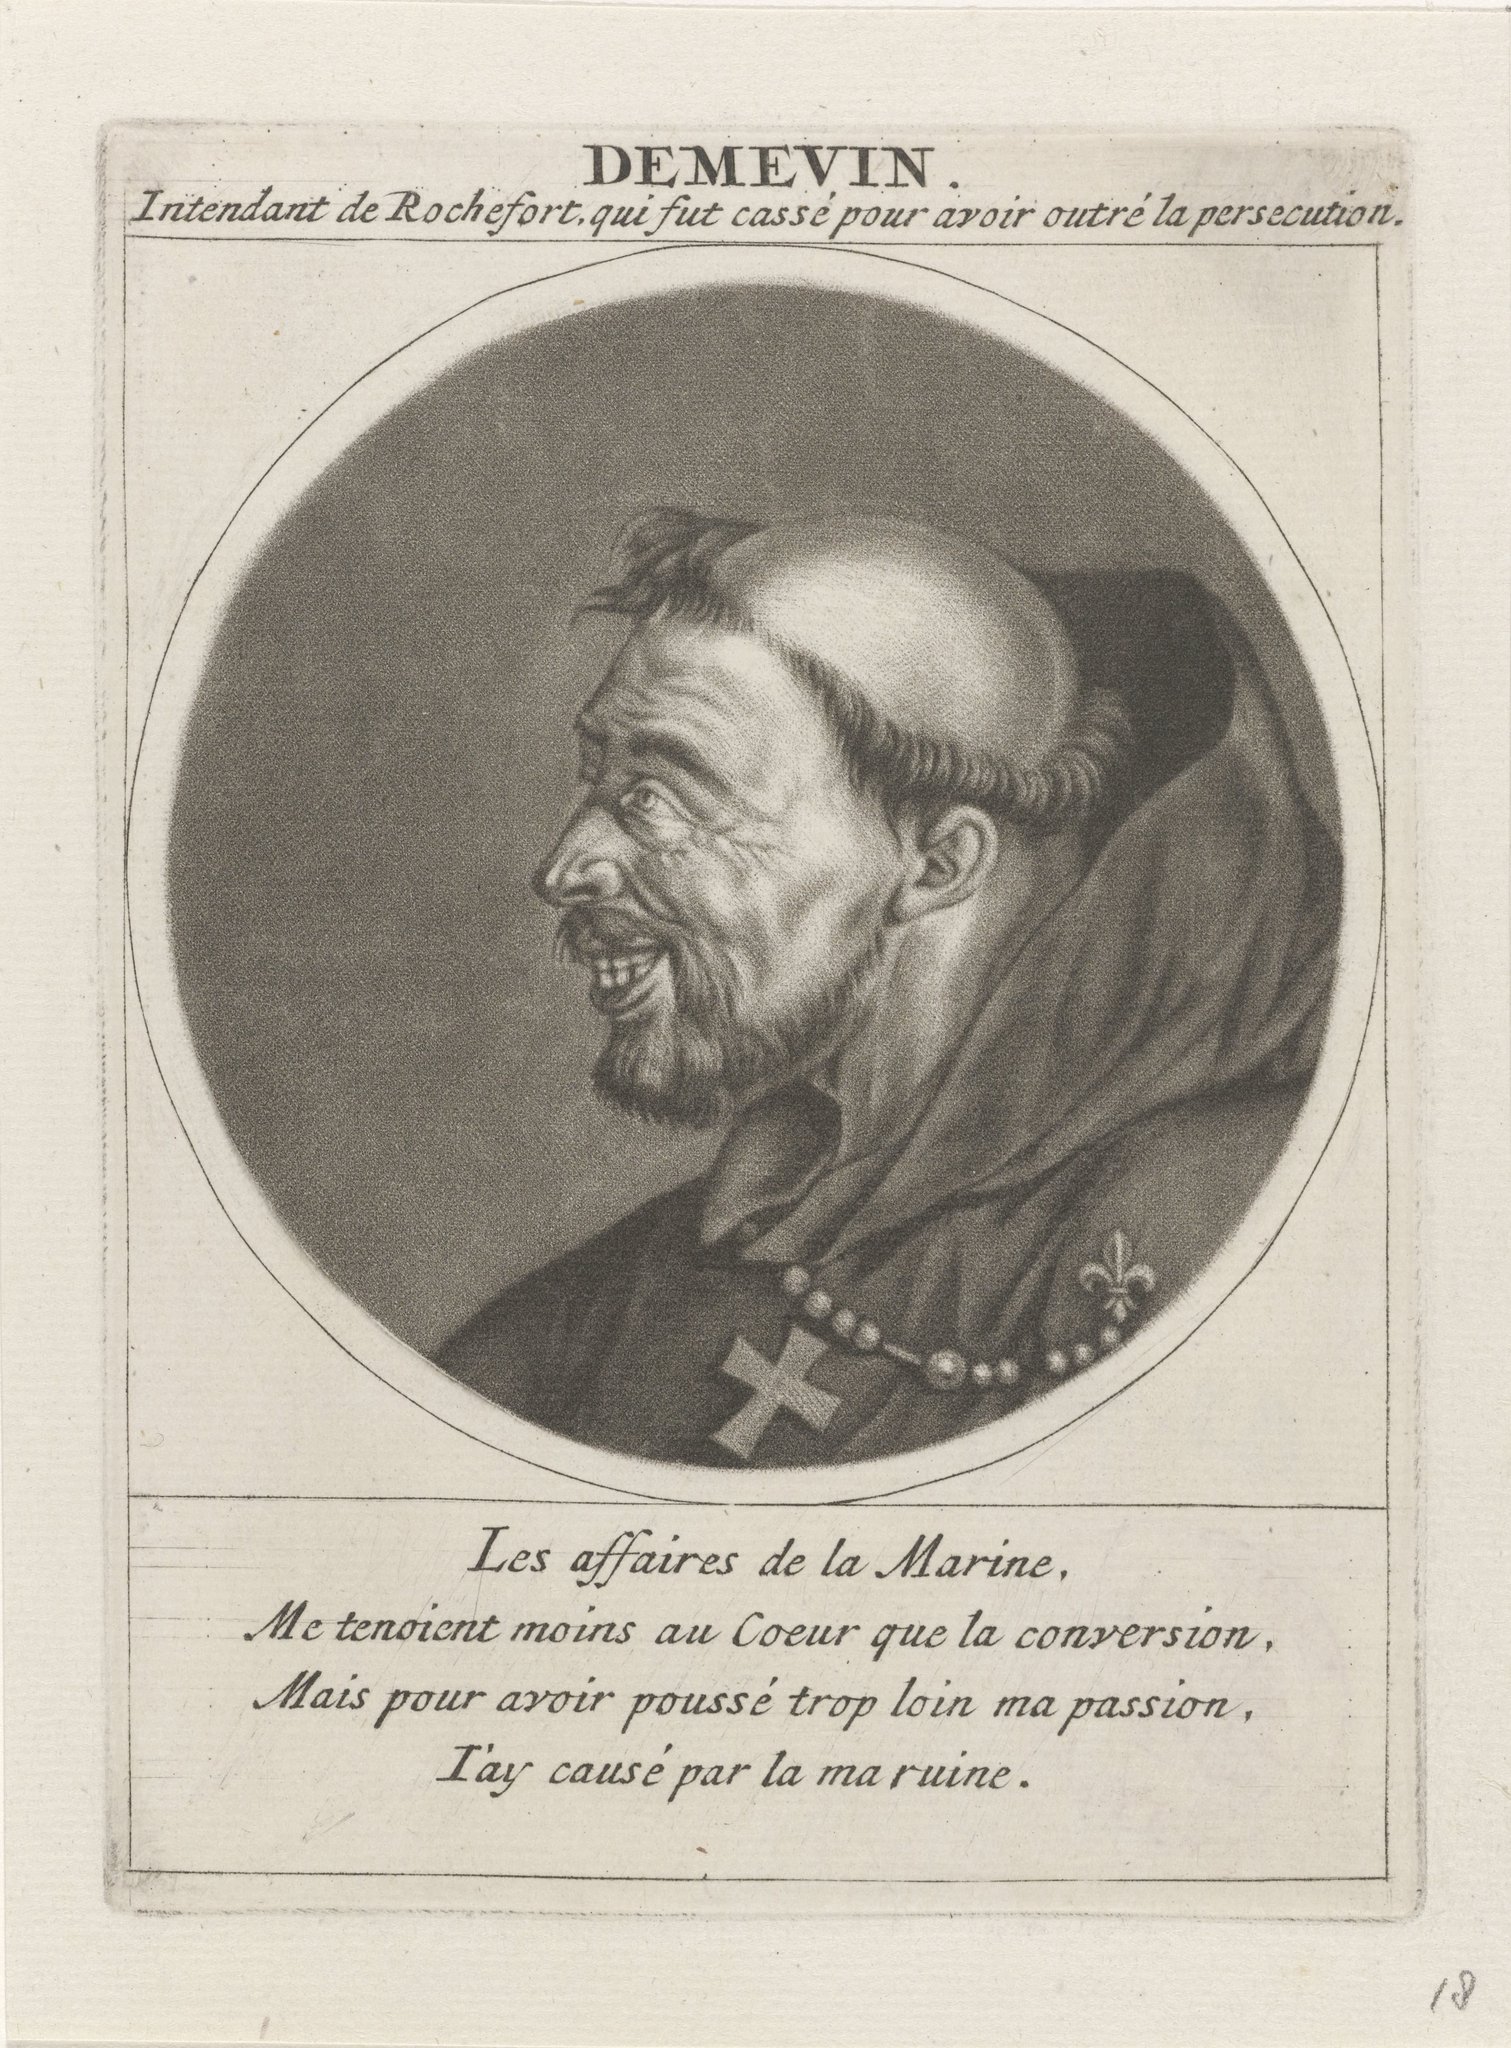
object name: print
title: Les Héros de la Ligue ou La Procession Monacale, conduitte par Louis XIV pour la Conversion des Protestans de son Royaume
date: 1691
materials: paper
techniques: engraving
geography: paris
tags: fleur-de-lis ~ ornament, political caricatures and satires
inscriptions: collector's mark: Lugt 240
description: Titelpagina voor: Les Heros de la Ligue: ou la procession monacale, conduitte par Louis XIV, pour la conversion des Protestants de son royaume. Chez. Pere Peters en Louis le Grand: Parijs, 1691. (De uitgevers zijn fictief.)